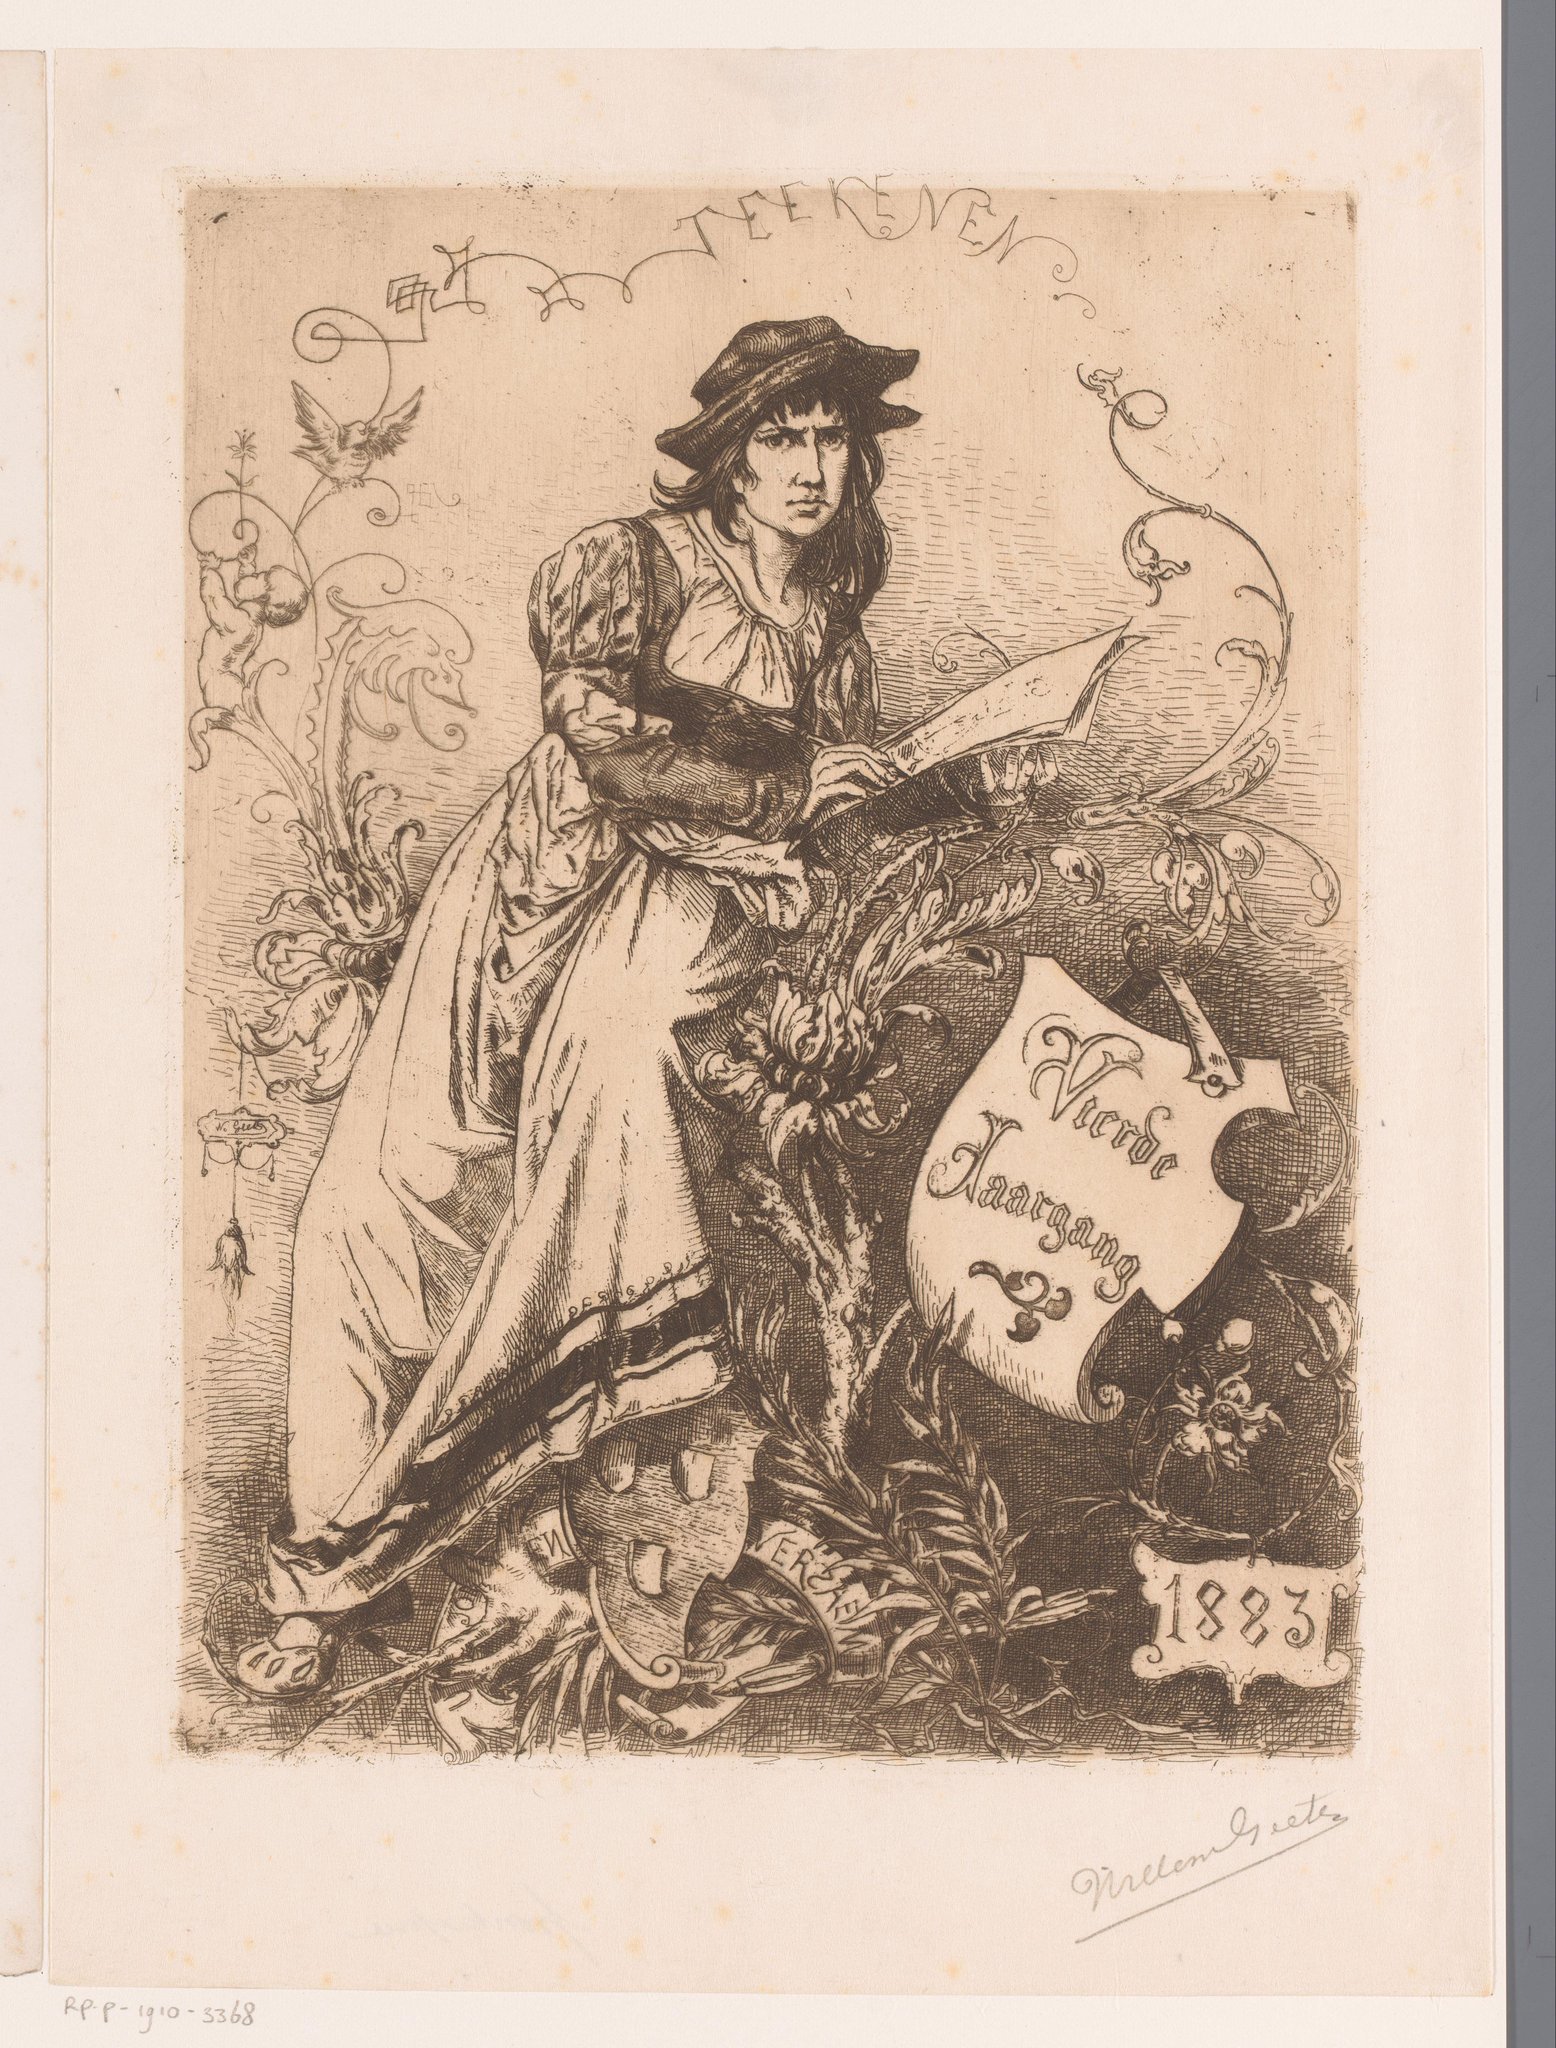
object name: print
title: Album der Antwerpsche Etsers 1883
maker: willem geets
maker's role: print maker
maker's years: 1838-1919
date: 1883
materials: paper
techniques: etching, intaglio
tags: adolescent, young woman, maiden, draughtsman at work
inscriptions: mark: ‘Antwerpsche Etsers 1880’, collector's mark: Lugt 2228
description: Waarschijnlijk titelprent voor: Album der Antwerpsche Etsers. S.l.: Vereeniging der Antwerpsche Etsers, 1883.